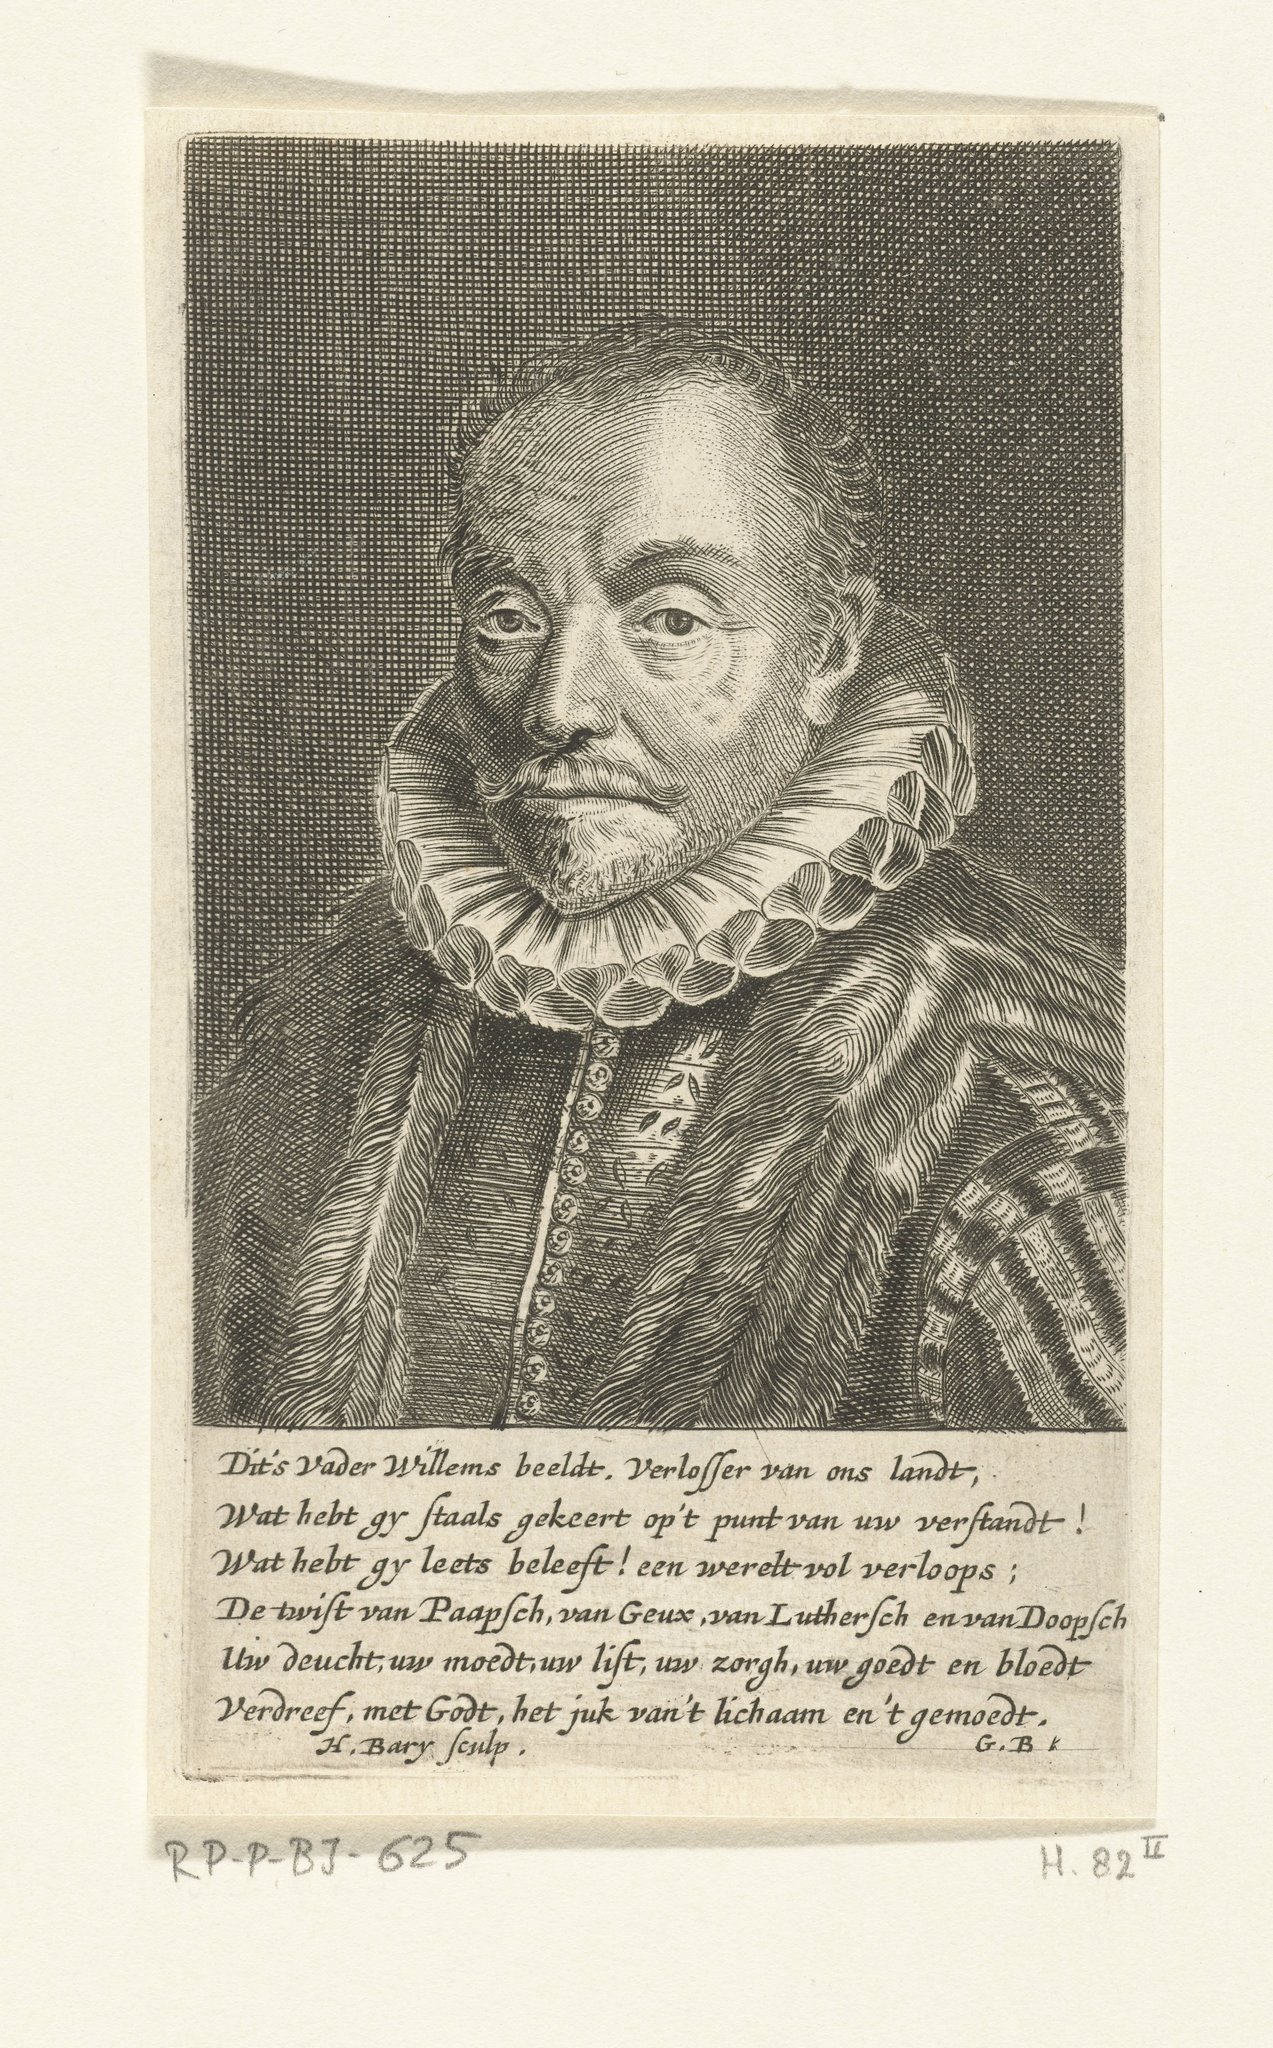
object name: print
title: Portret van Willem I, prins van Oranje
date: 1657-1707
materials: paper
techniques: engraving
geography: netherlands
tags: delft, william i (prince of orange)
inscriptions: collector's mark: Lugt 2228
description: Portret van Willem I, prins van Oranje. Onder het portret een vers van zes regels in het Nederlands van G. Brandt.